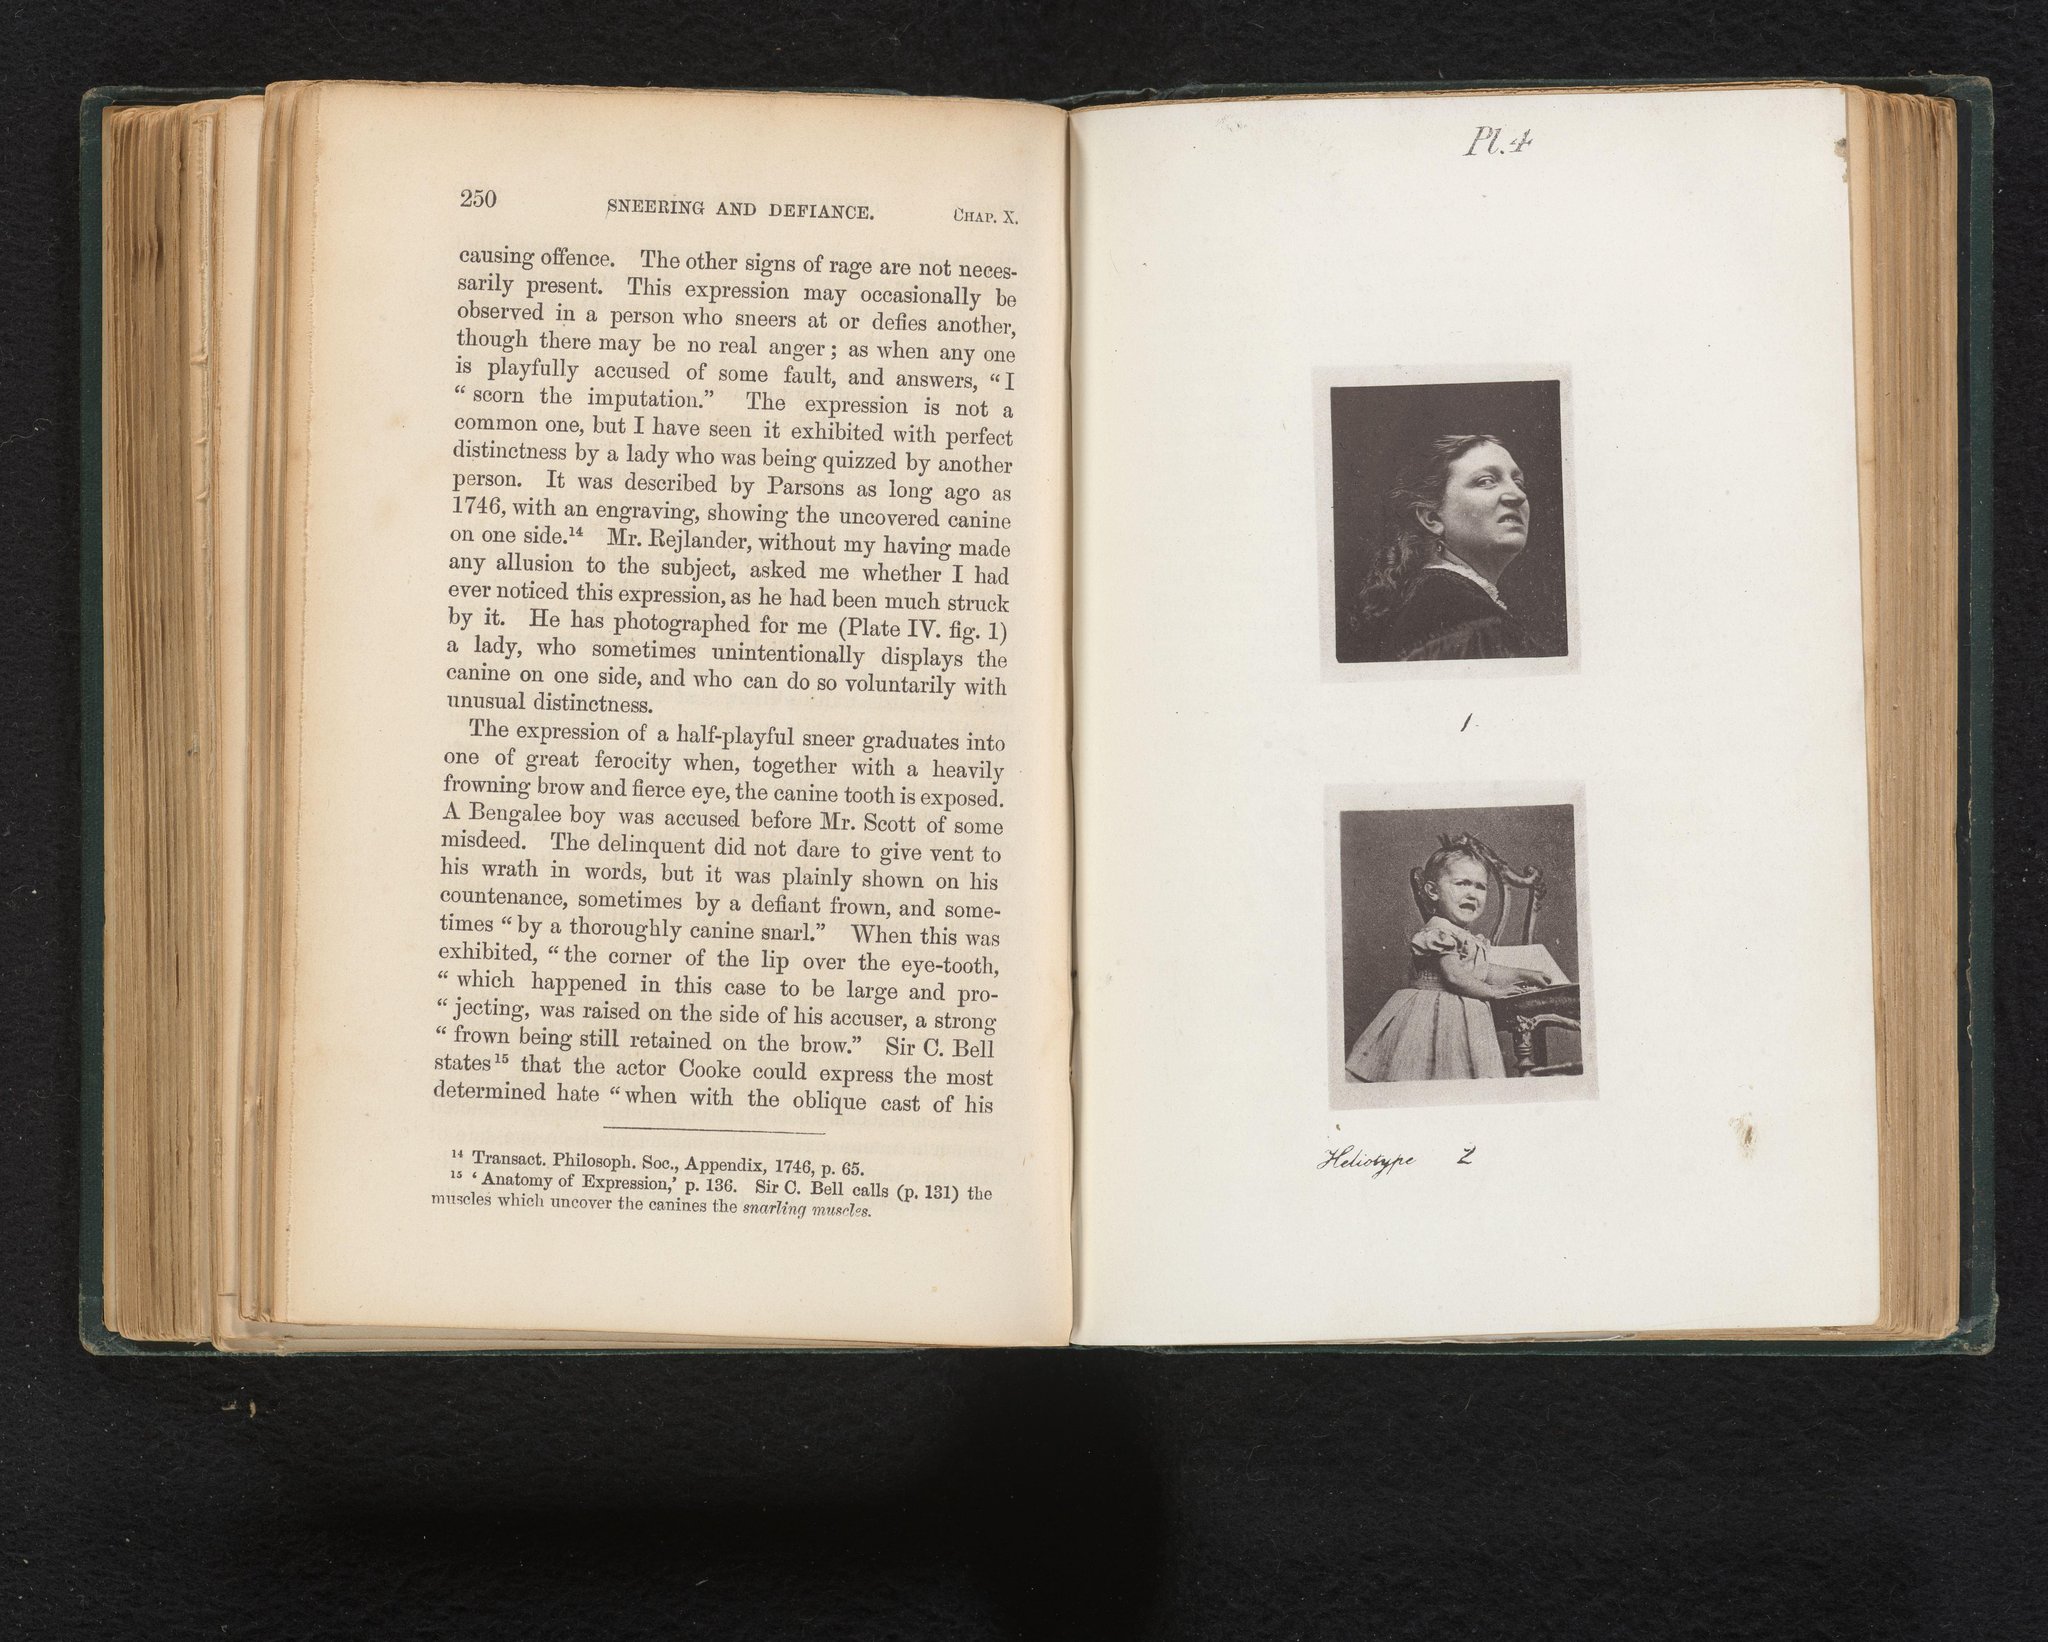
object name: photomechanical print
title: Twee foto's van mensen ter illustratie van verschillende gezichtsuitdrukkingen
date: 1867-1872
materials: paper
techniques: photoaquatint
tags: historical persons - bb - woman, morphology of facial expression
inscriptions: inscription: ‘Pl.4’